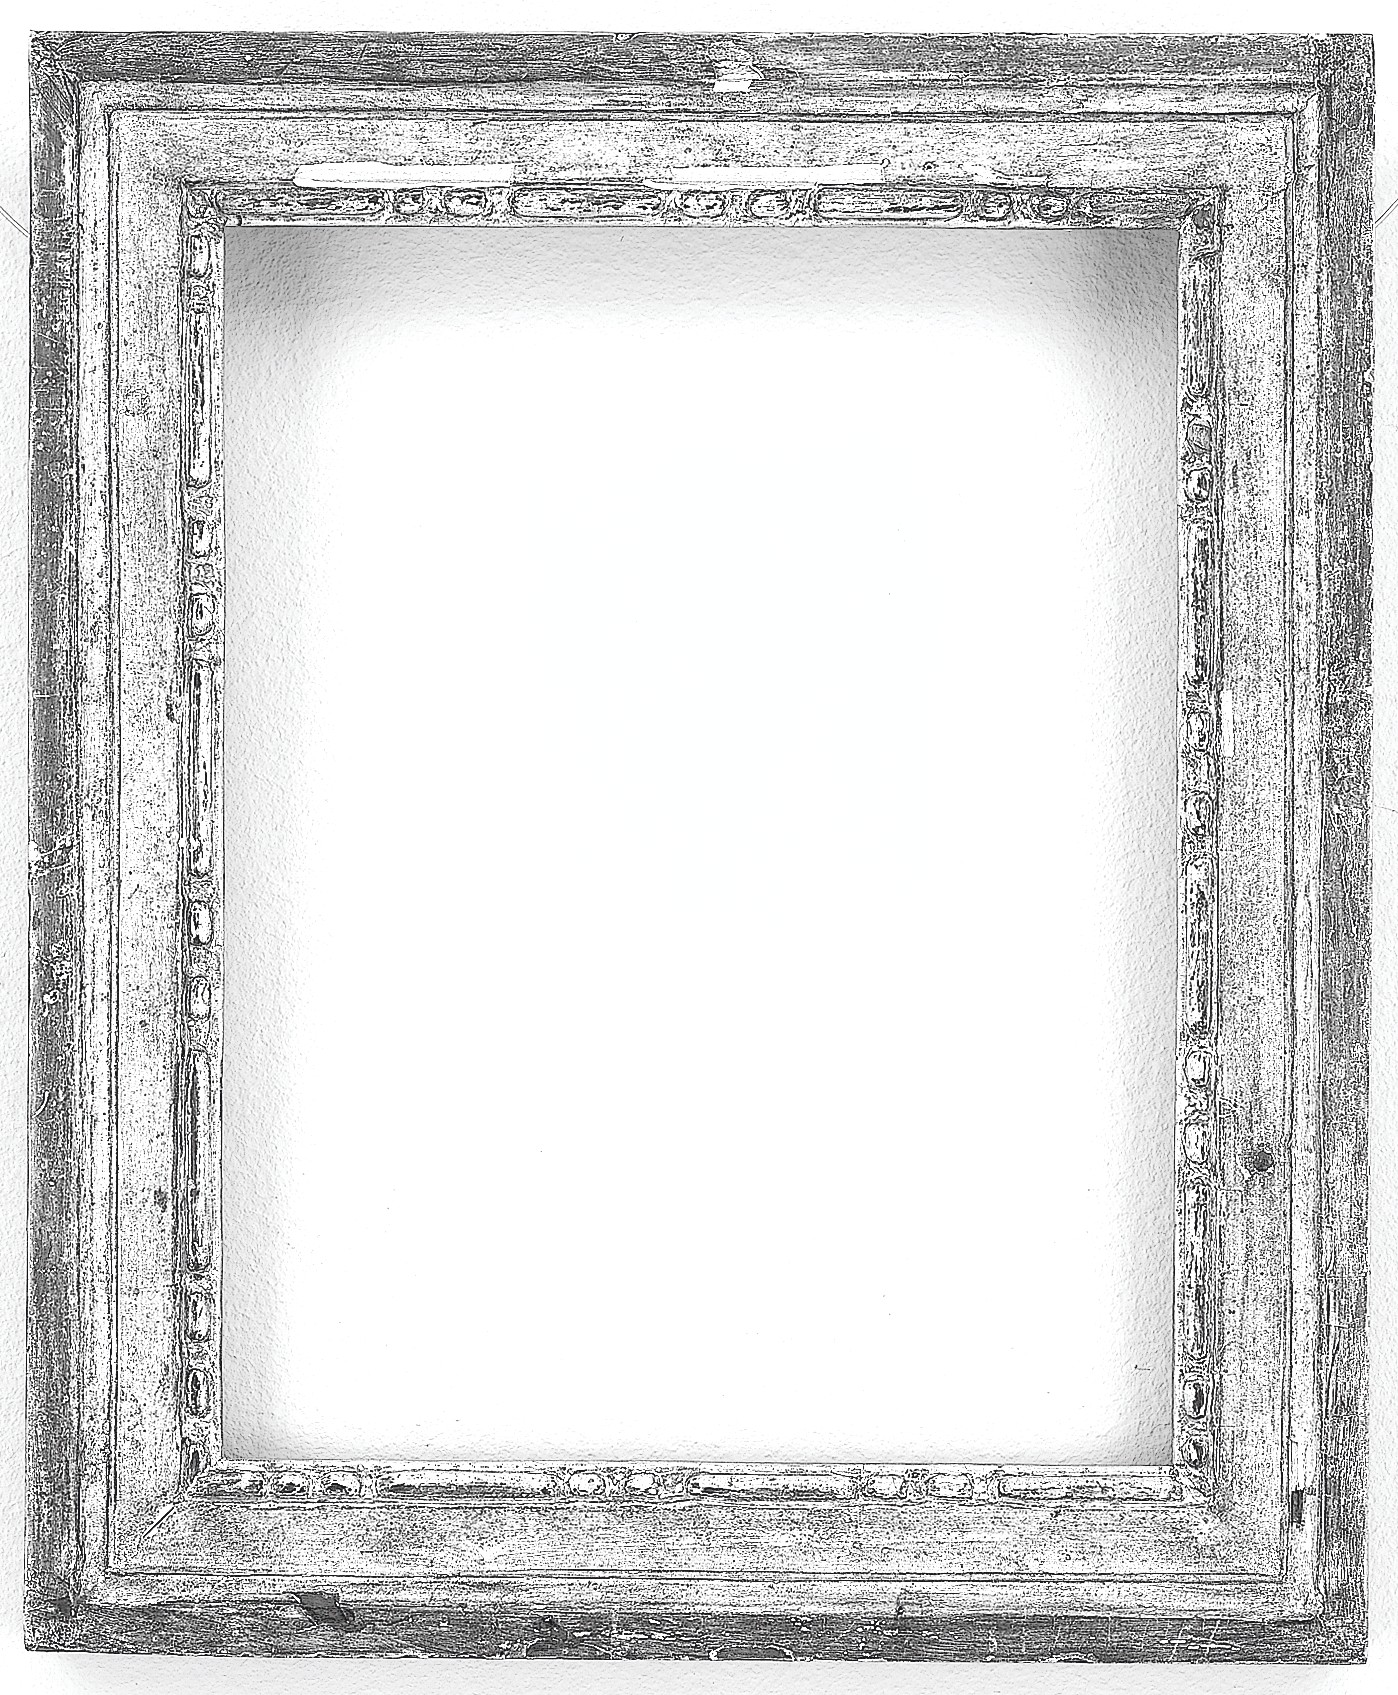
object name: frame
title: Cassetta frame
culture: german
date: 1800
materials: wood